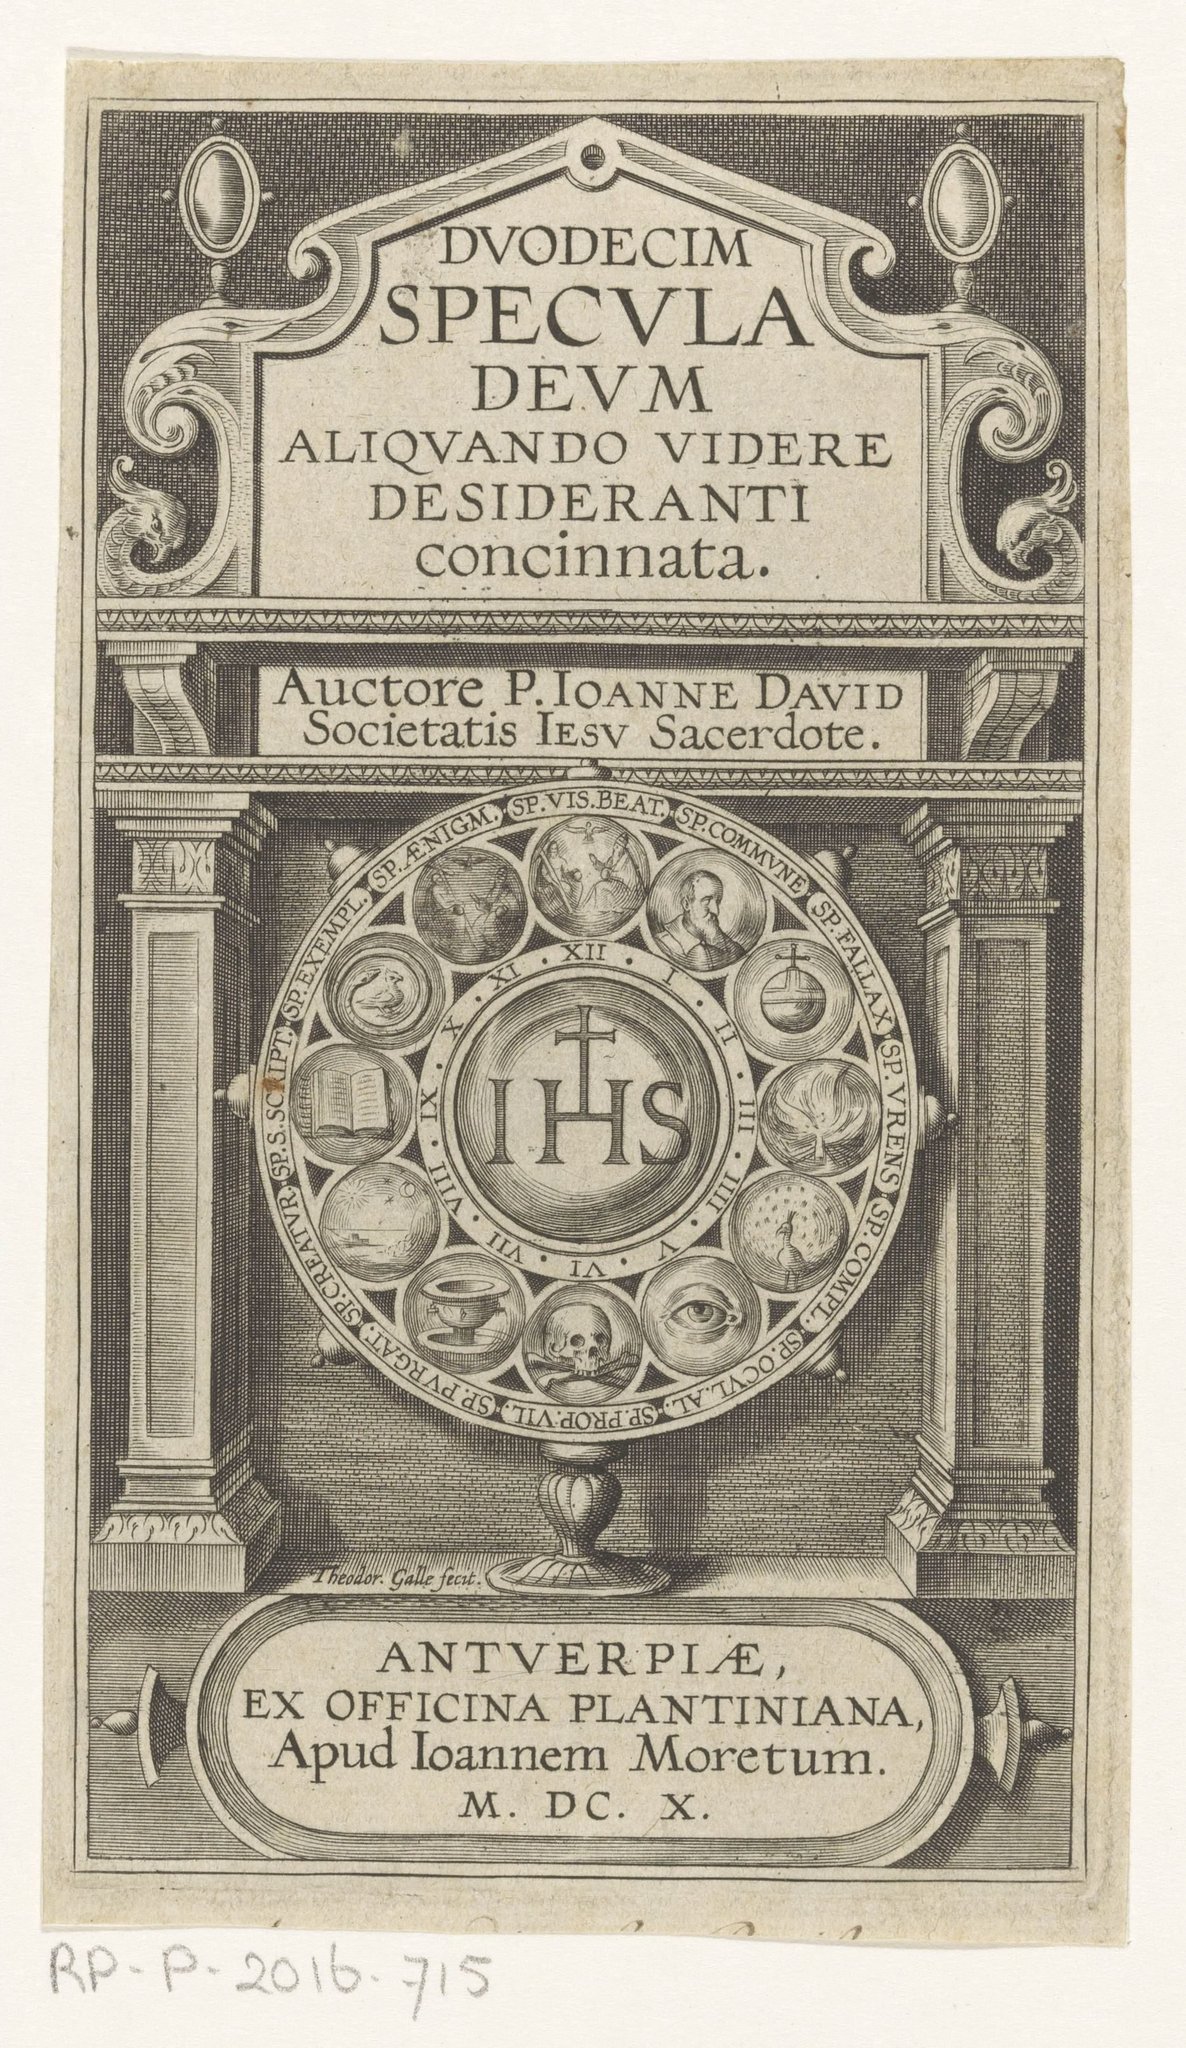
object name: print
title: Titelpagina voor: Jan David, Duodecim Specula Deum, 1610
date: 1610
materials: paper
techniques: engraving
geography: antwerp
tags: ihs ('iesus hominum salvator') ~ symbol of christ, mirror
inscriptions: collector's mark: Lugt 2228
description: In een klassiek bouwwerk bovenaan de titel van het werk. Centraal een spiegel bestaande uit twaalf kleine spiegels rondom een grote spiegel. De twaalf kleine spiegels zijn met Romeins cijfers genummerd en tonen de twaalf manieren waarmee de mens probeert God te zien: door de spiegel der gemeenschap (een mannenhoofd), de spiegel der bedrog (een wereldbol), de spiegel van vuur (een vuur), de spiegel der welbehagen (een pauw), de spiegel der vermaardheid (een oog), de spiegel van het leven (een doodskop), de spiegel der reinheid (een fontein), spiegel der schepping (de zon en de maan), spiegel van het Heilig Schrift (de Bijbel), spiegel van het voorbeeld (een vogel), spiegel der toespelingen (de Drie-eenheid in een donkere spiegel) en spiegel der gelukzaligheid (de Drie-eenheid in een klare spiegel). De grote spiegel in het midden toont de initialen IHS (Iesus Hominum Salvator).